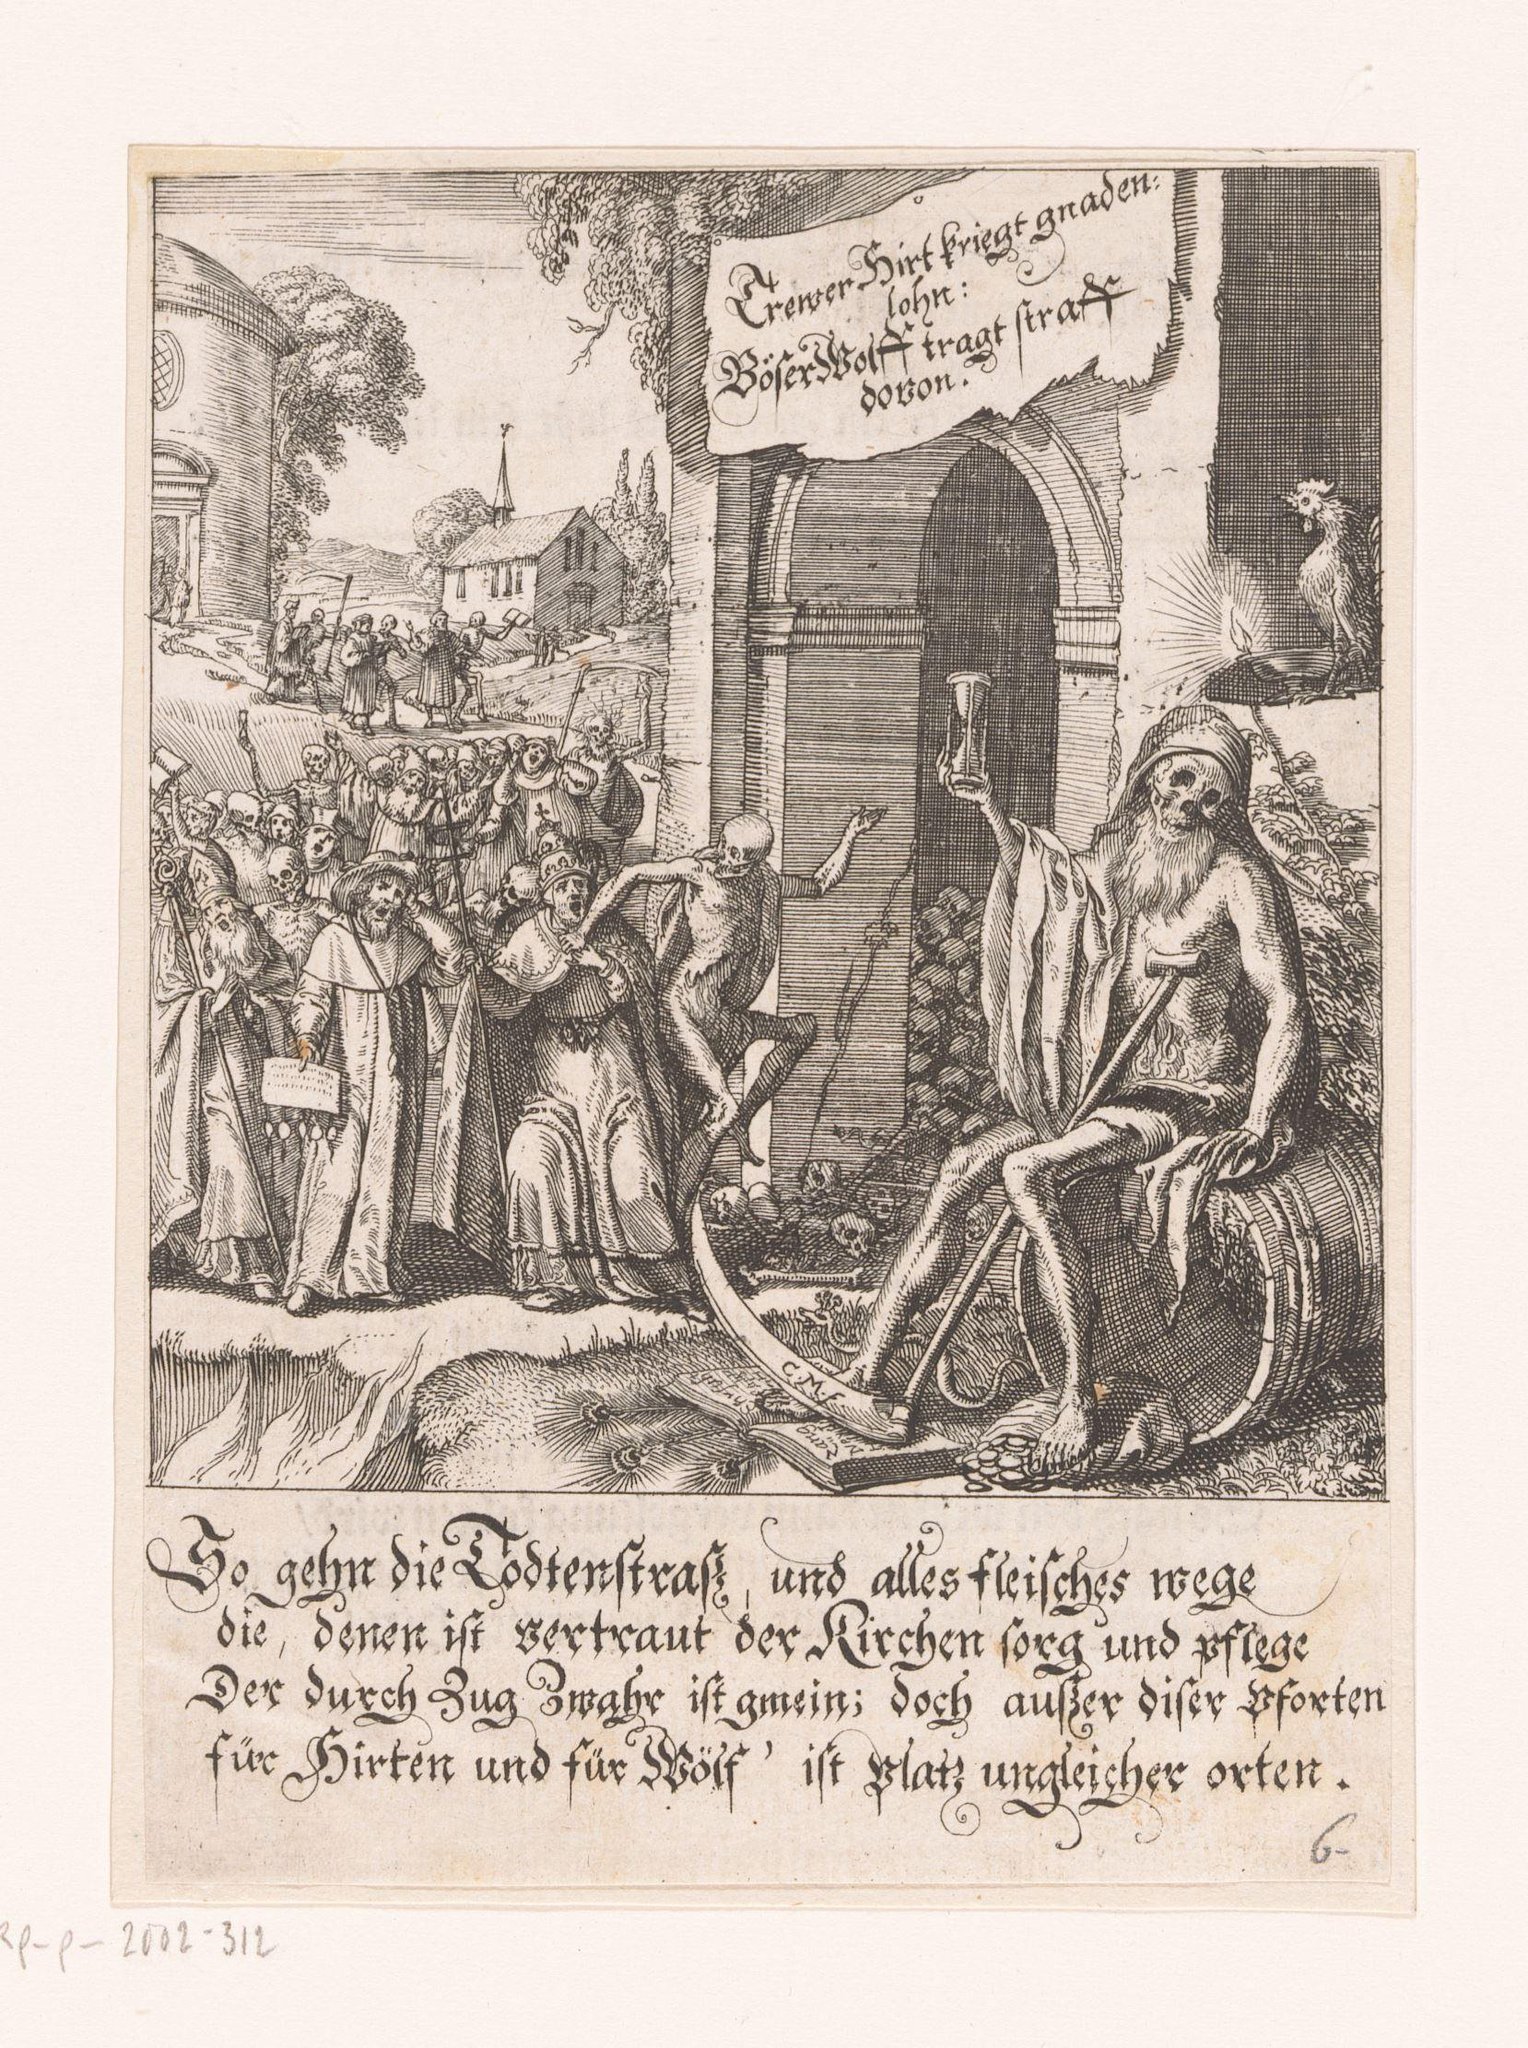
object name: book illustration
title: Dodenstraf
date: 1650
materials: paper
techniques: etching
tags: personifications of death; 'morte' (ripa), dance of death; death together with one or more human beings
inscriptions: collector's mark: Lugt 2233, collector's mark: Lugt 2228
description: De goede en slechte mensen worden gescheiden na de dood en ontvangen hun beloning of straf. De Dood zit als skelet met zeis en zandloper rechtsvoor op een ton. Boven zijn hoofd kraait een haan. Een stoet geestelijken, met de paus voorop, wordt naar een poort geleid.